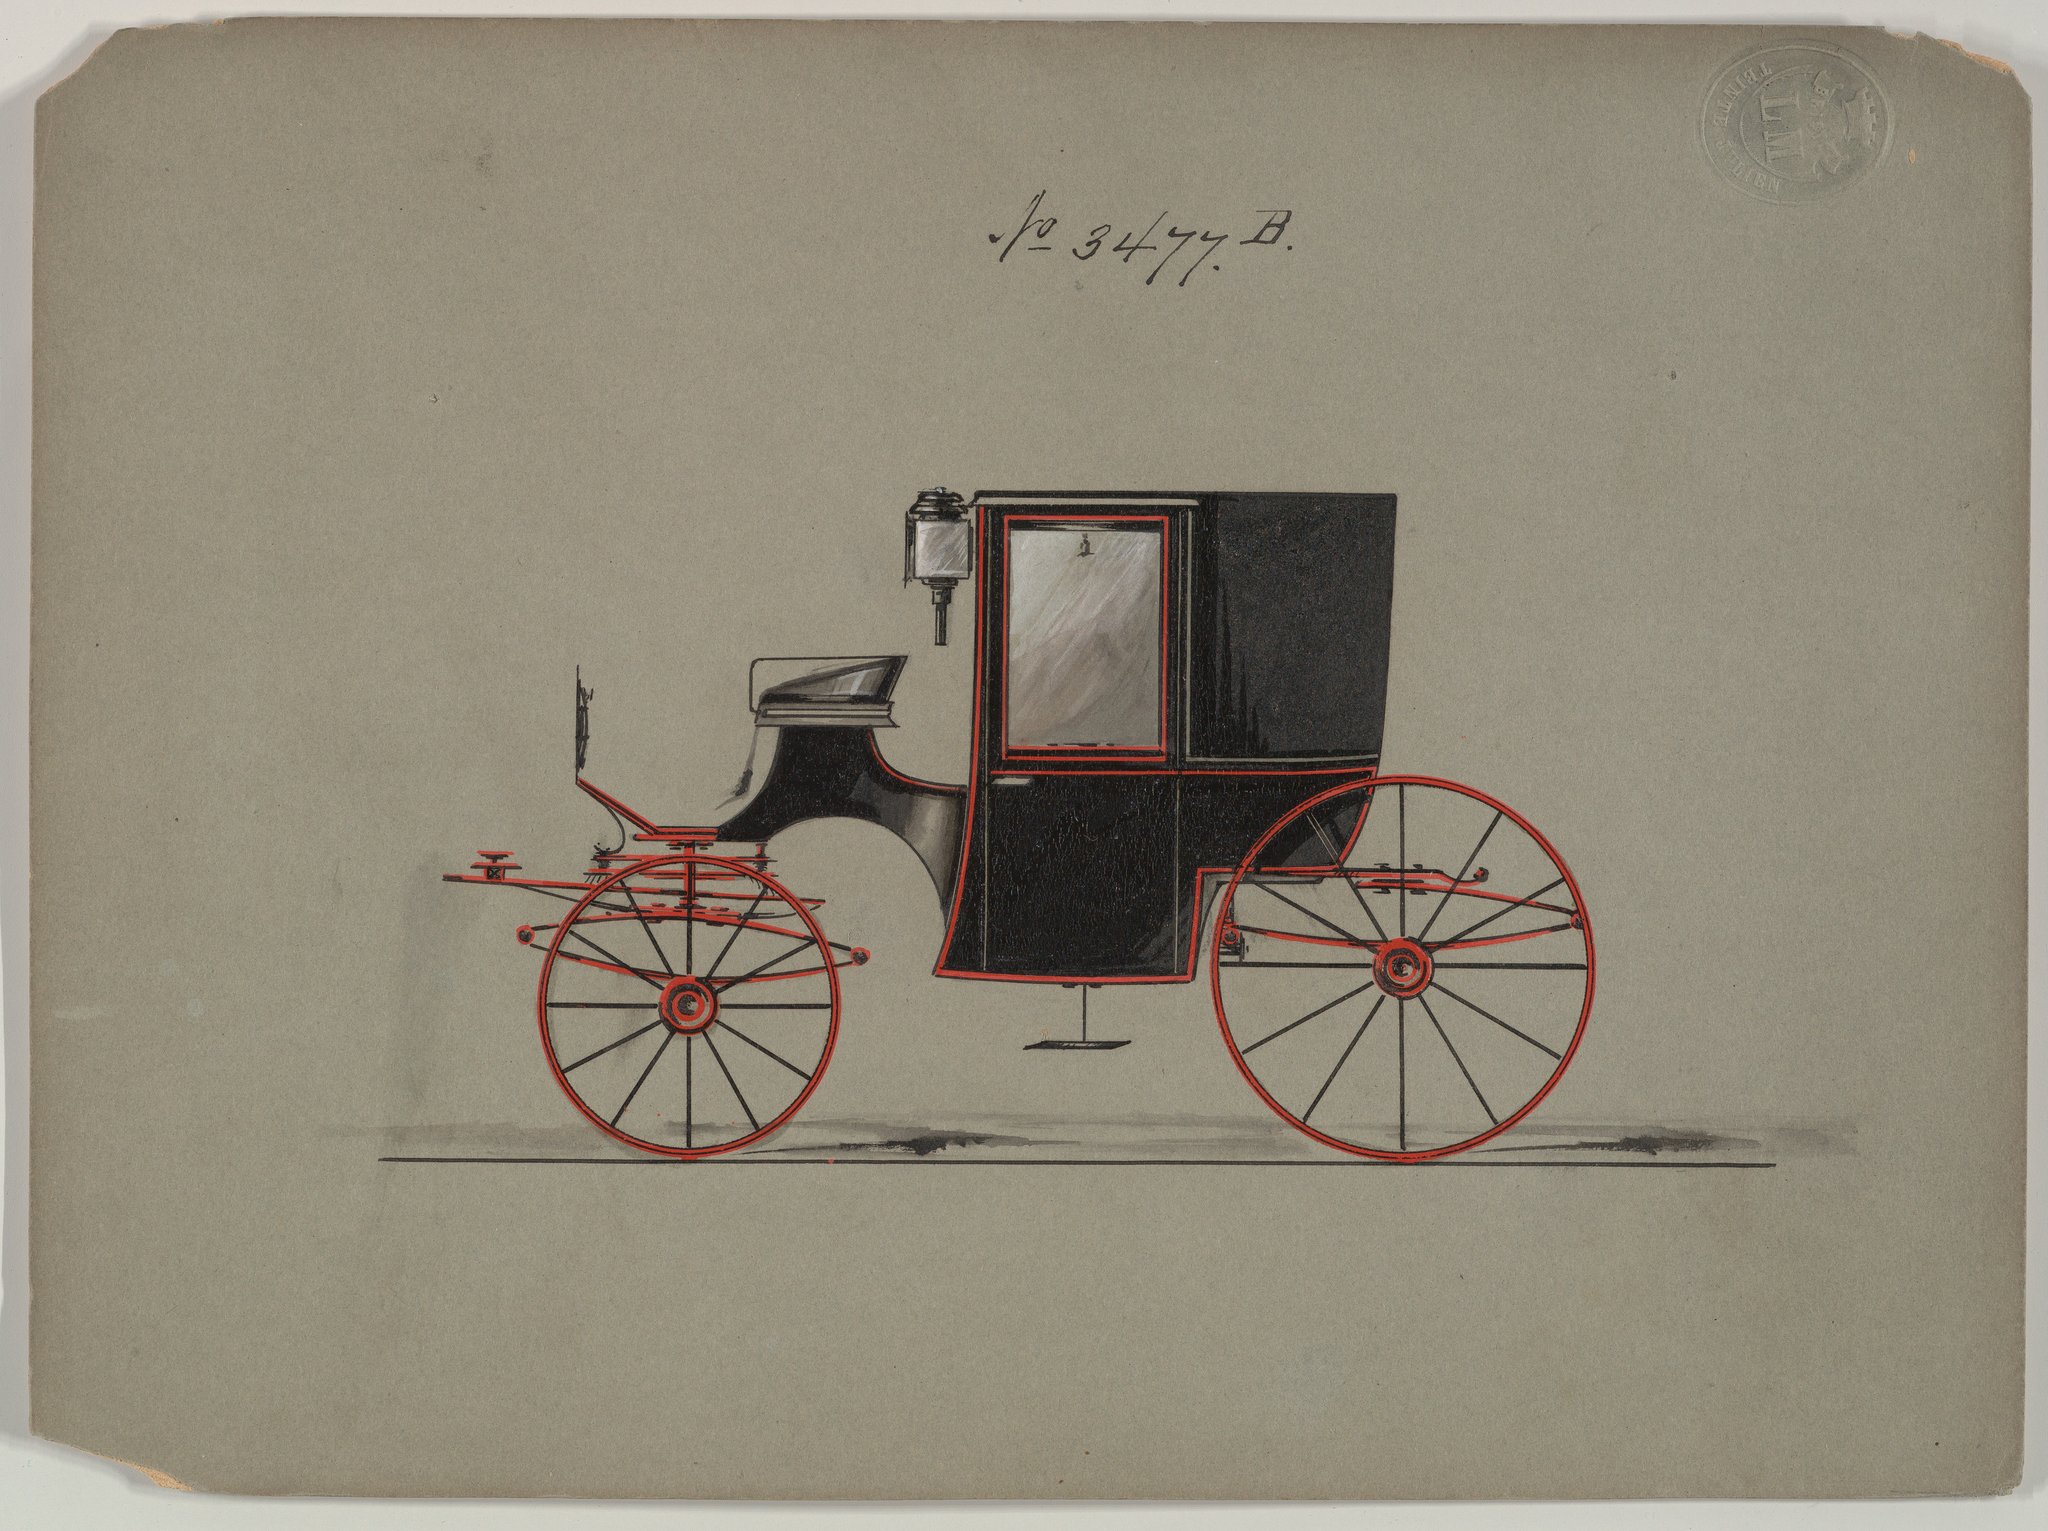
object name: drawing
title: Brougham #3477b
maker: brewster & co.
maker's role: manufacturer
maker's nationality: american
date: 1878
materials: gouache, gum arabic, ink, watercolor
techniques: pen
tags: carriages